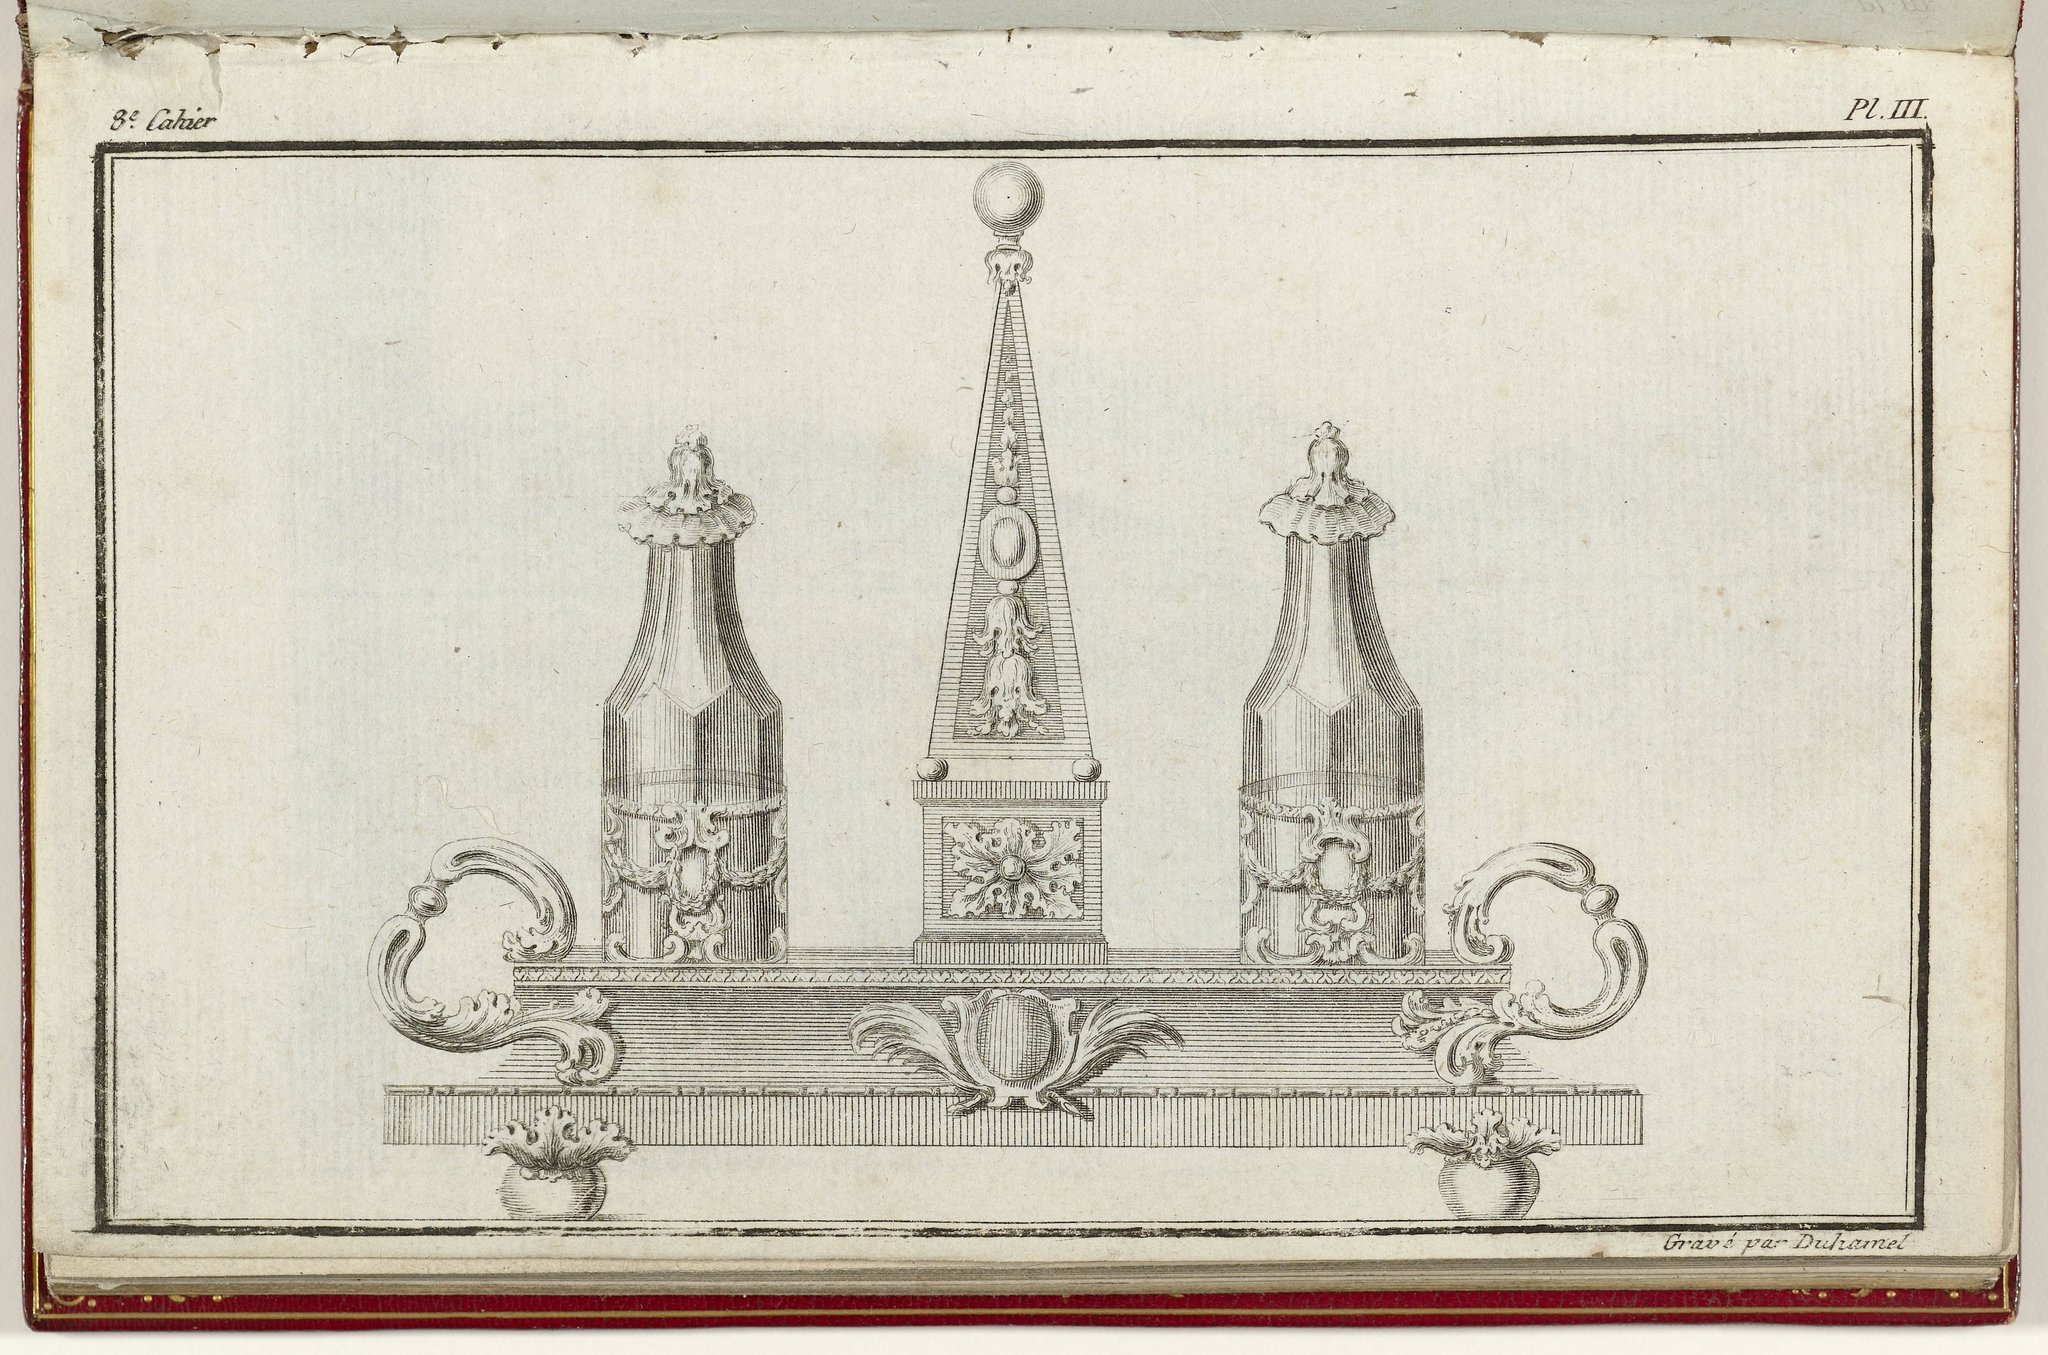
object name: book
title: Cabinet des Modes ou les Modes Nouvelles, 1 Mars 1786, pl. III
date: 1786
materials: paper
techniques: engraving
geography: paris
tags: fashion plates